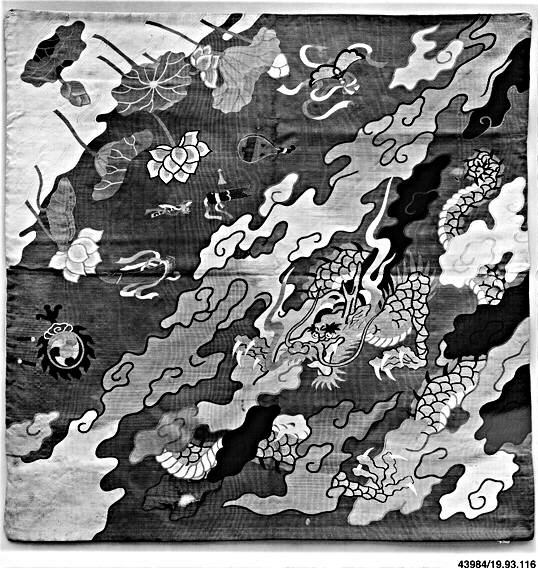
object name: gift cloth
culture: japanese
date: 1701-1800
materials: metal thread, silk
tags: dragons